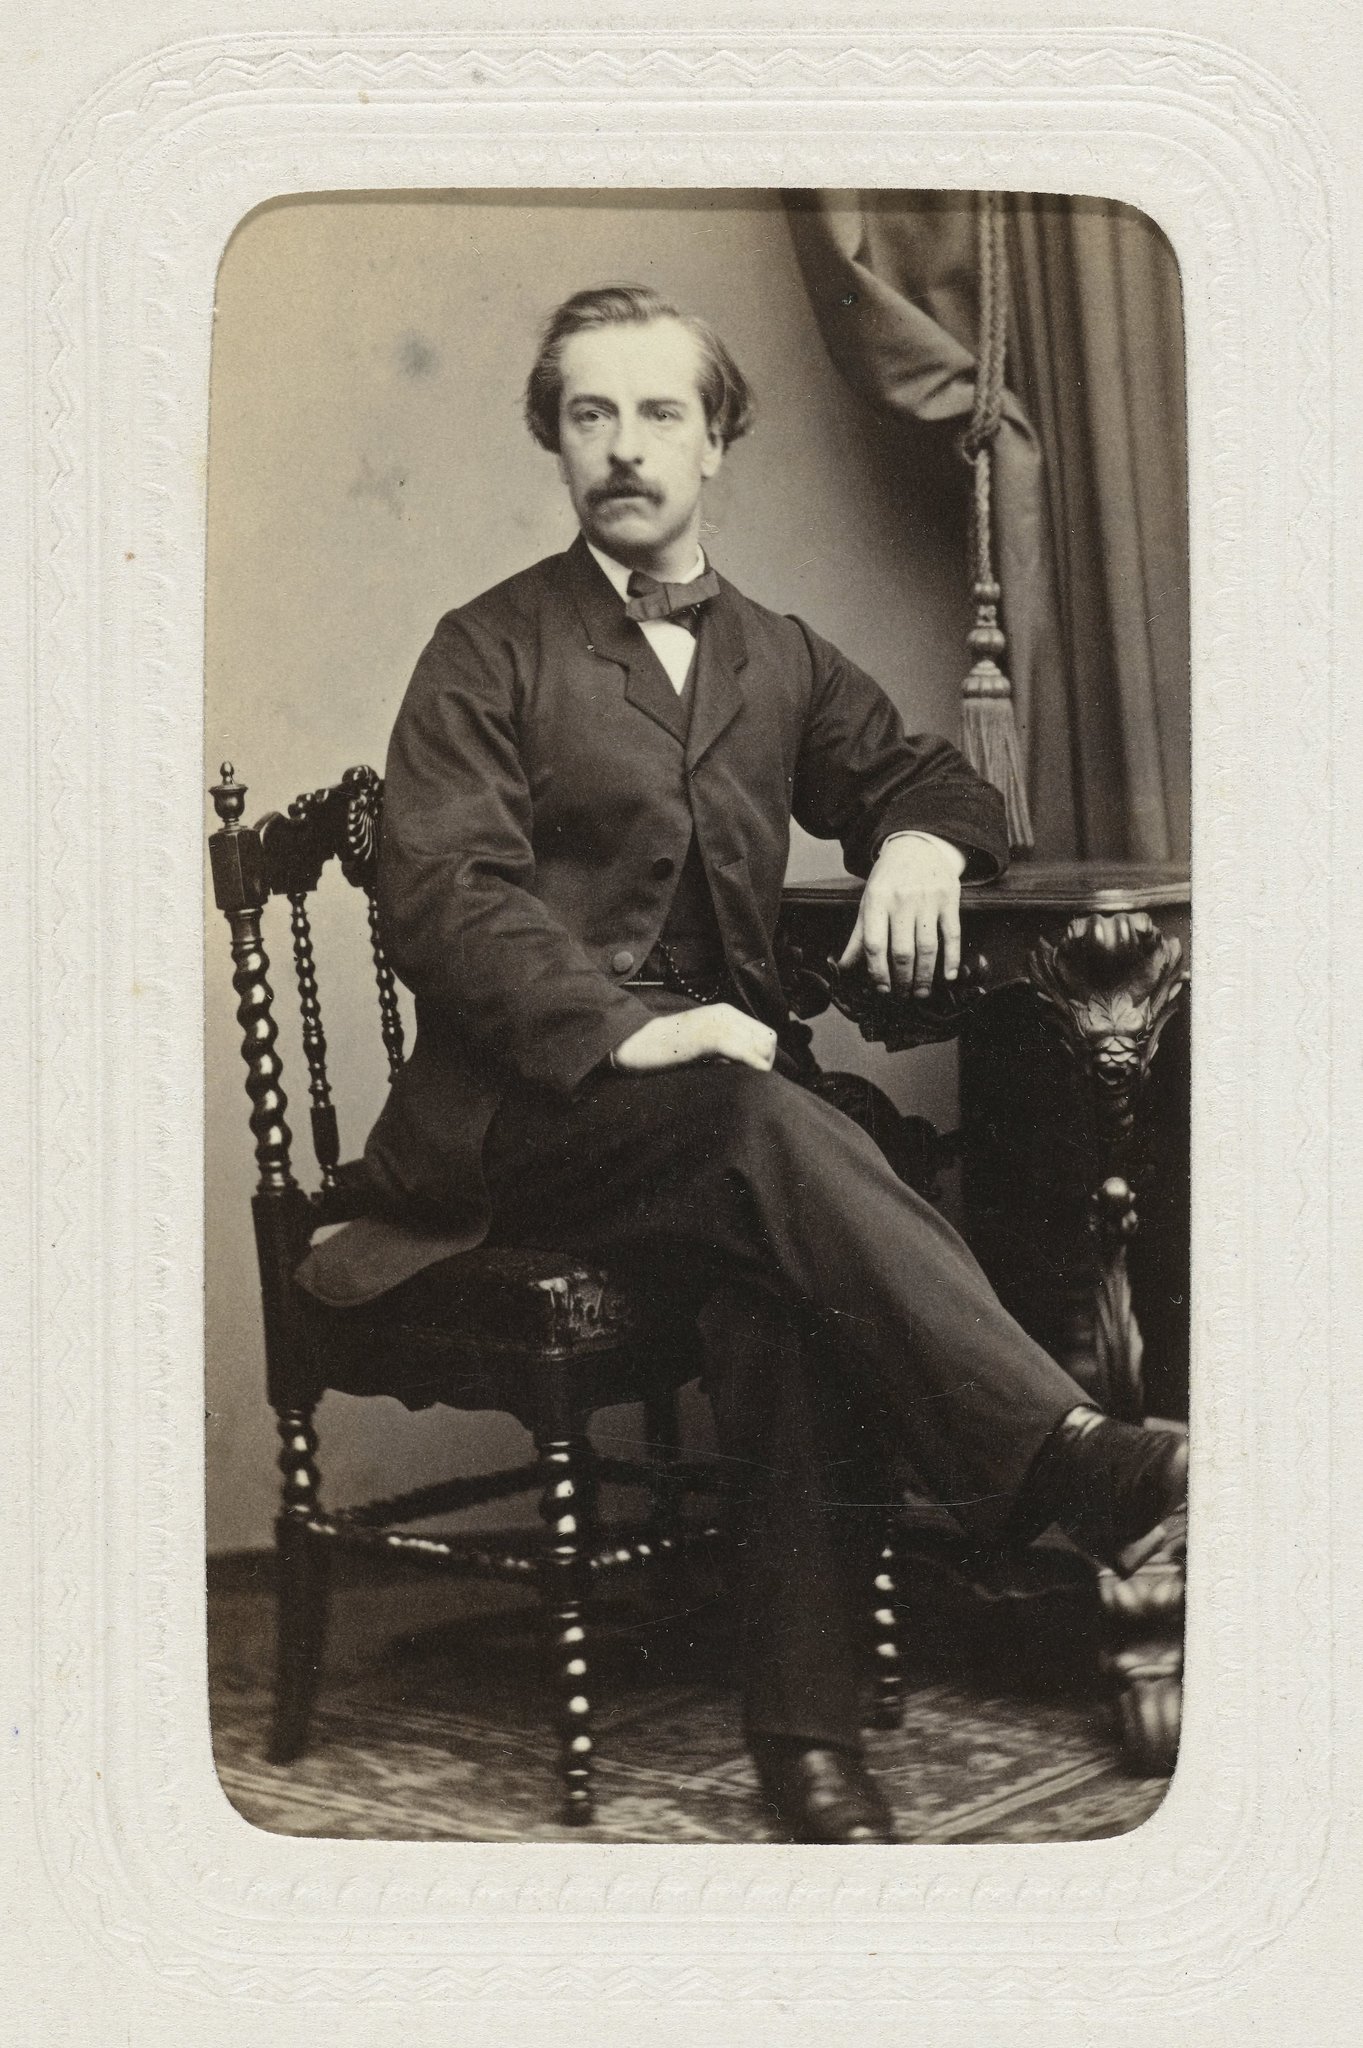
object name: carte de visite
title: Studioportret van een man met snor op een stoel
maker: carl rensing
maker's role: fotograaf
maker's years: 1826-1898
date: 1863-1866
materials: cardboard, paper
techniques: albumen print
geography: amsterdam